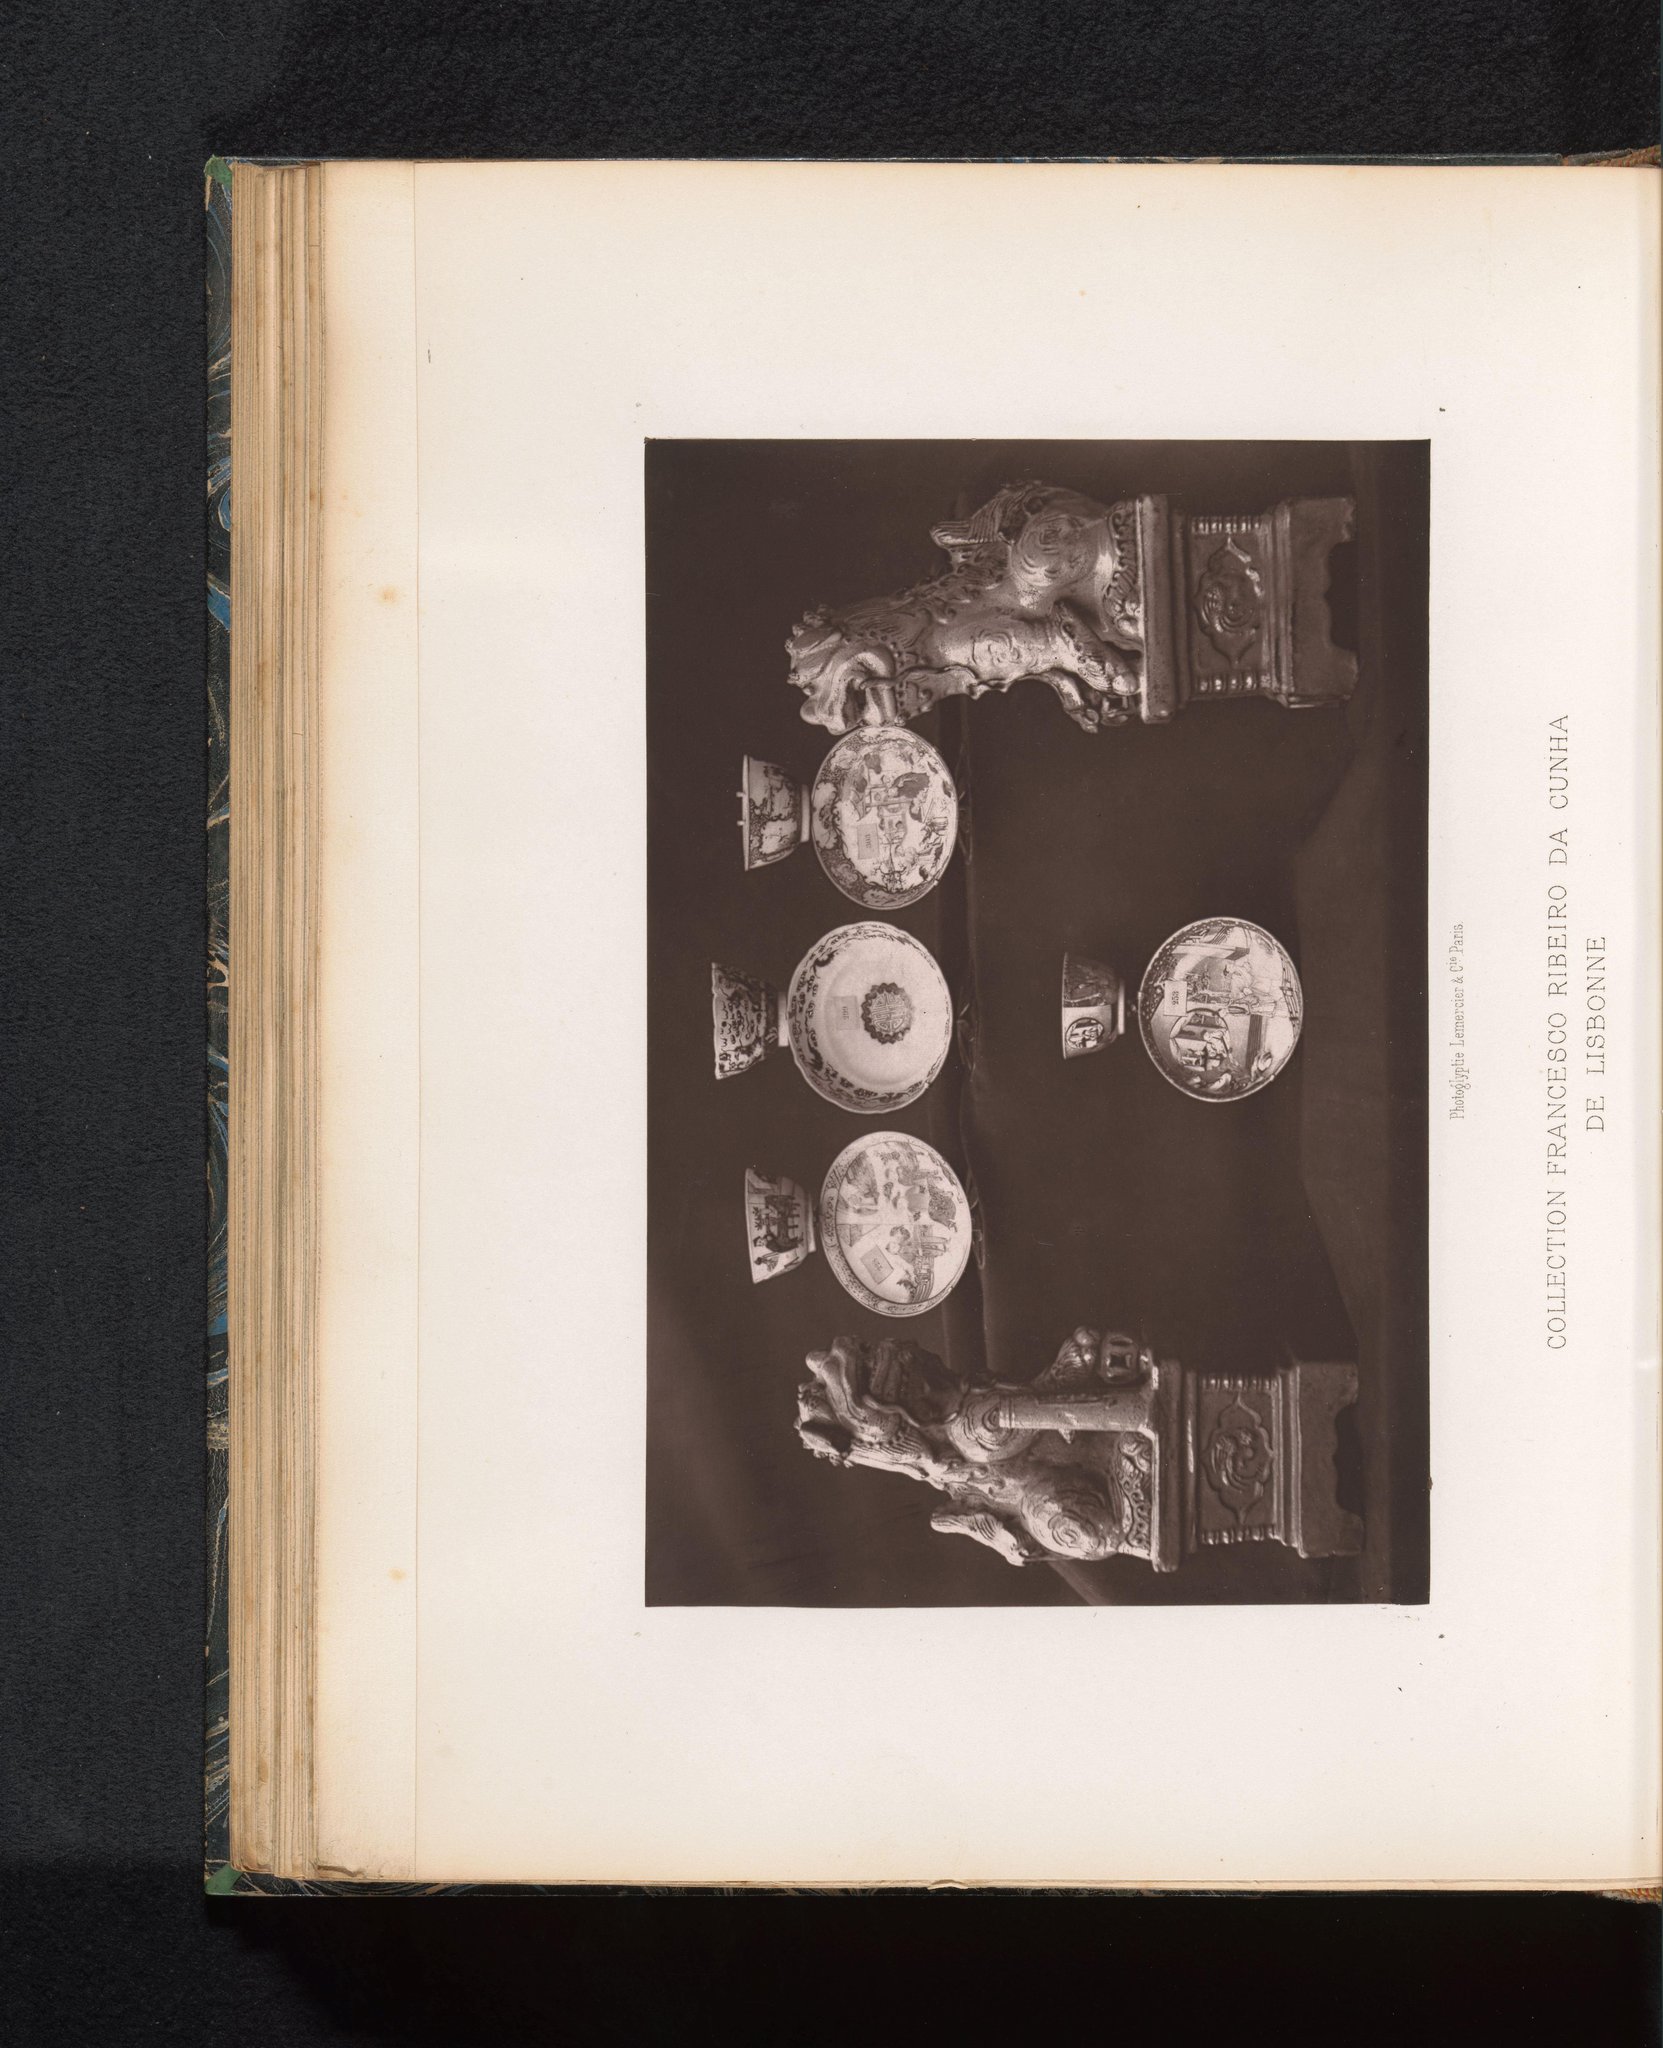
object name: page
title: Kop en schotels met twee leeuwenbeelden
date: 1879-1884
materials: paper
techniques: woodburytype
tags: beasts of prey, predatory animals: lion, cup and saucer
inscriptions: inscription: ‘Collection Francesco Riberio da Cunha de Lisbonne’